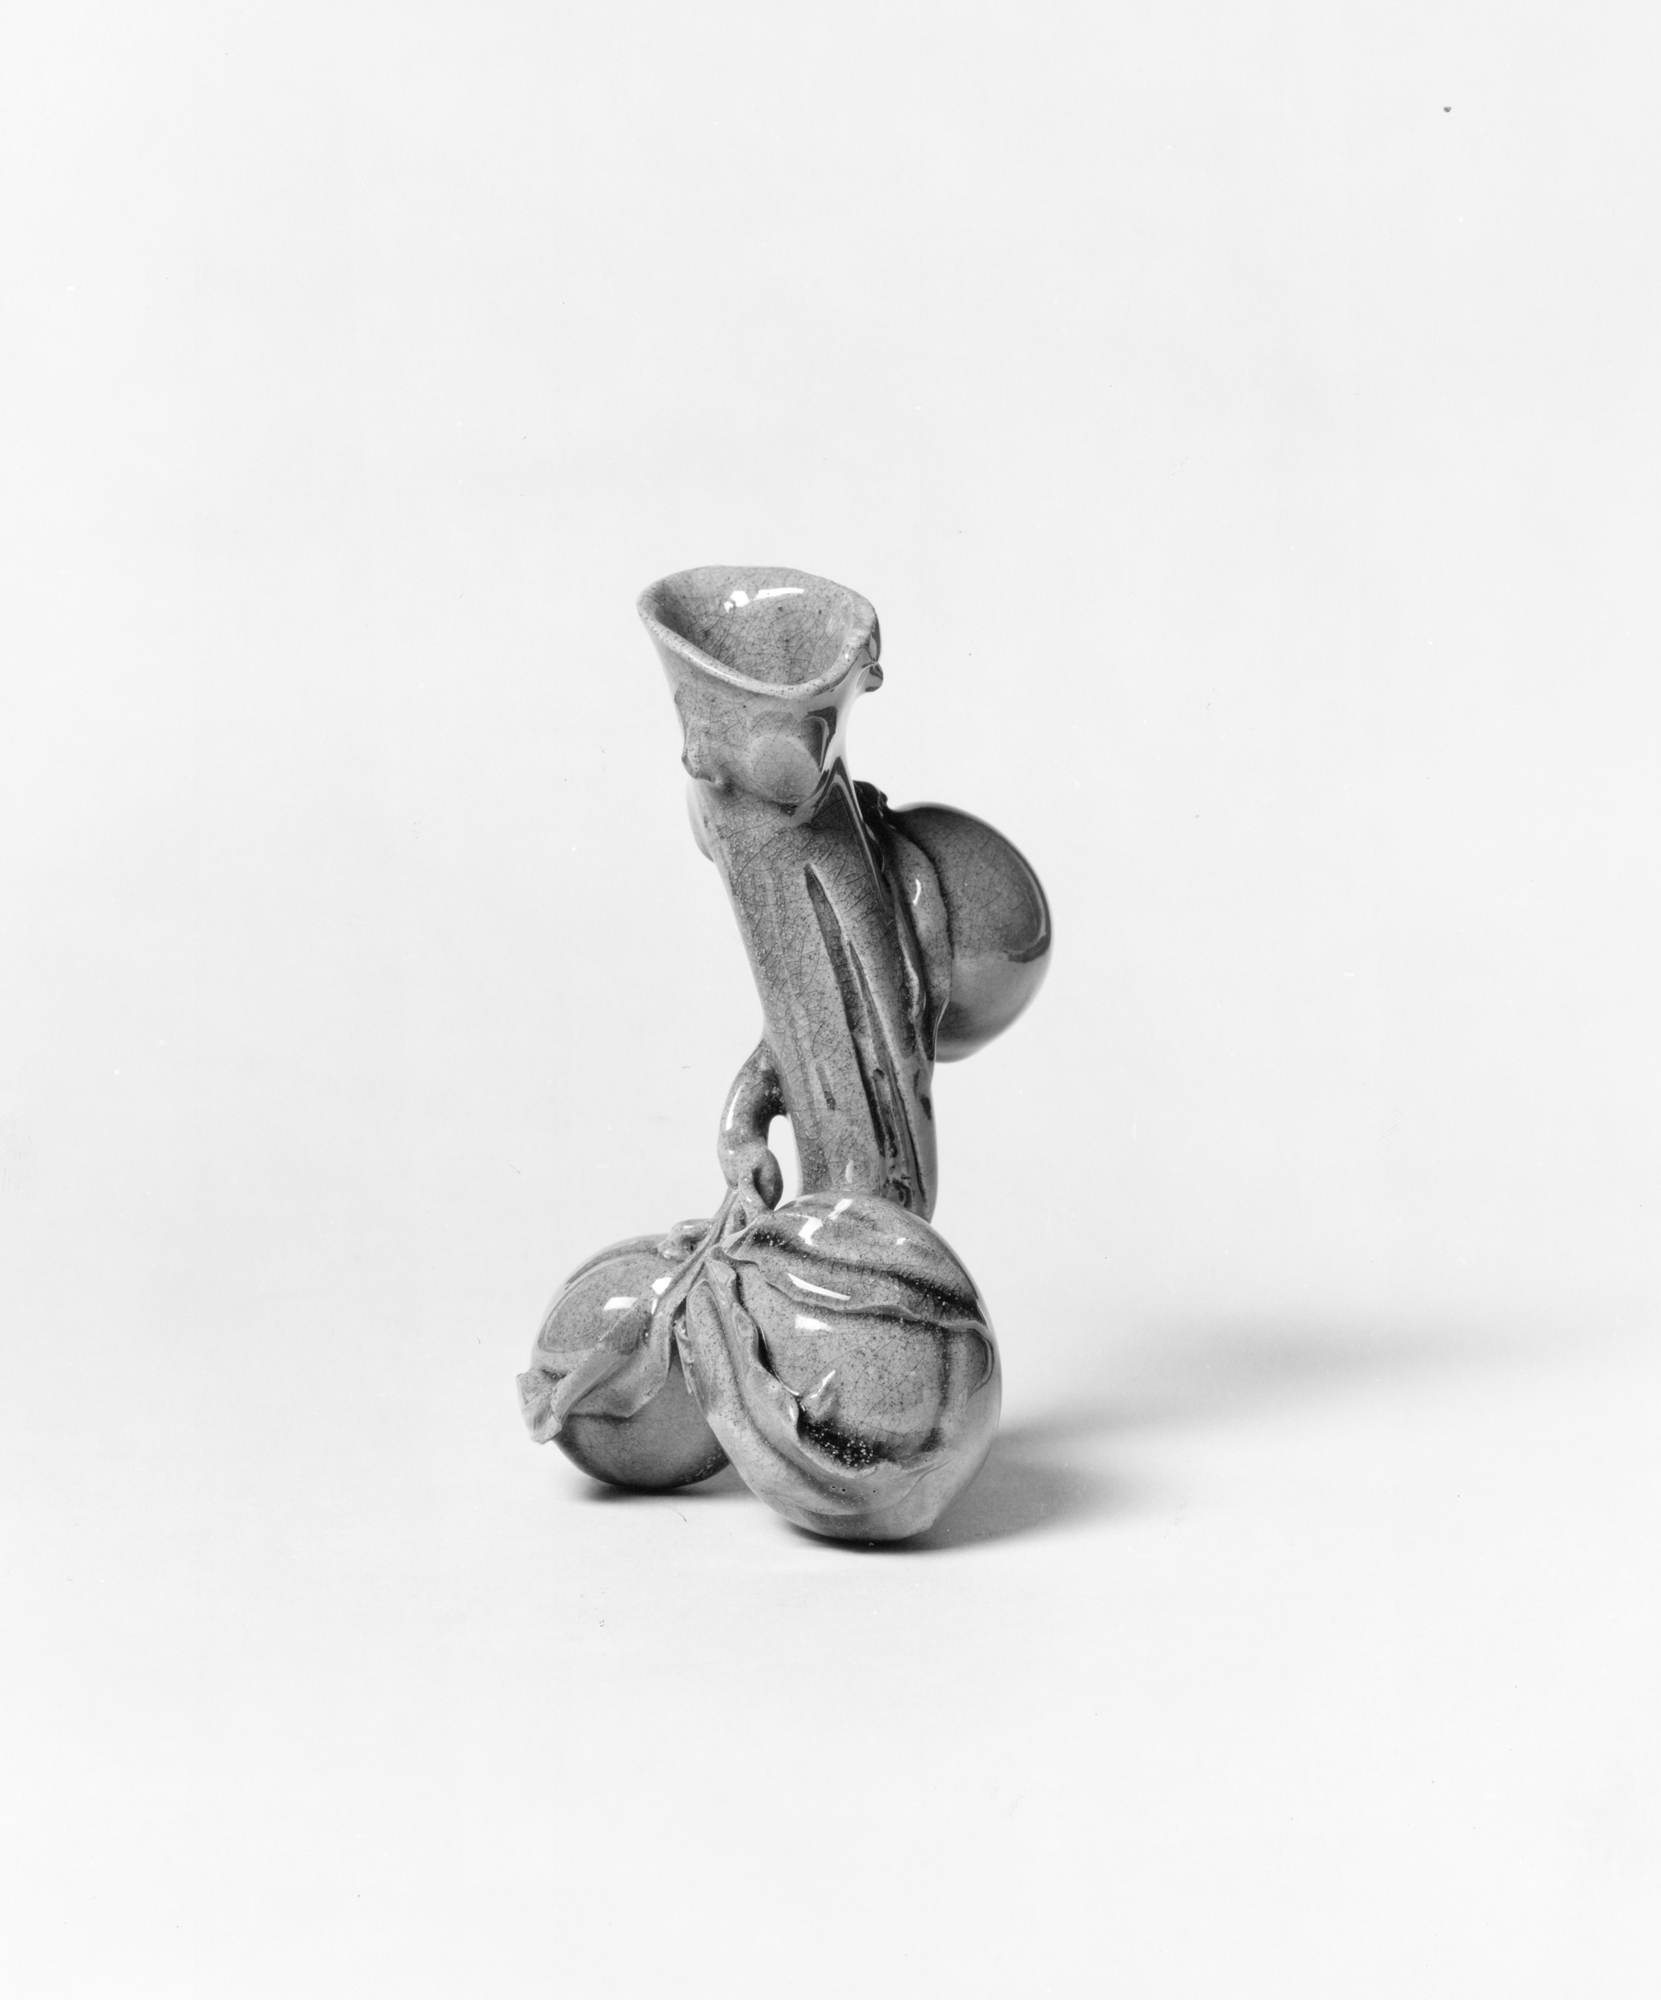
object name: vase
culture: chinese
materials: glaze, stoneware